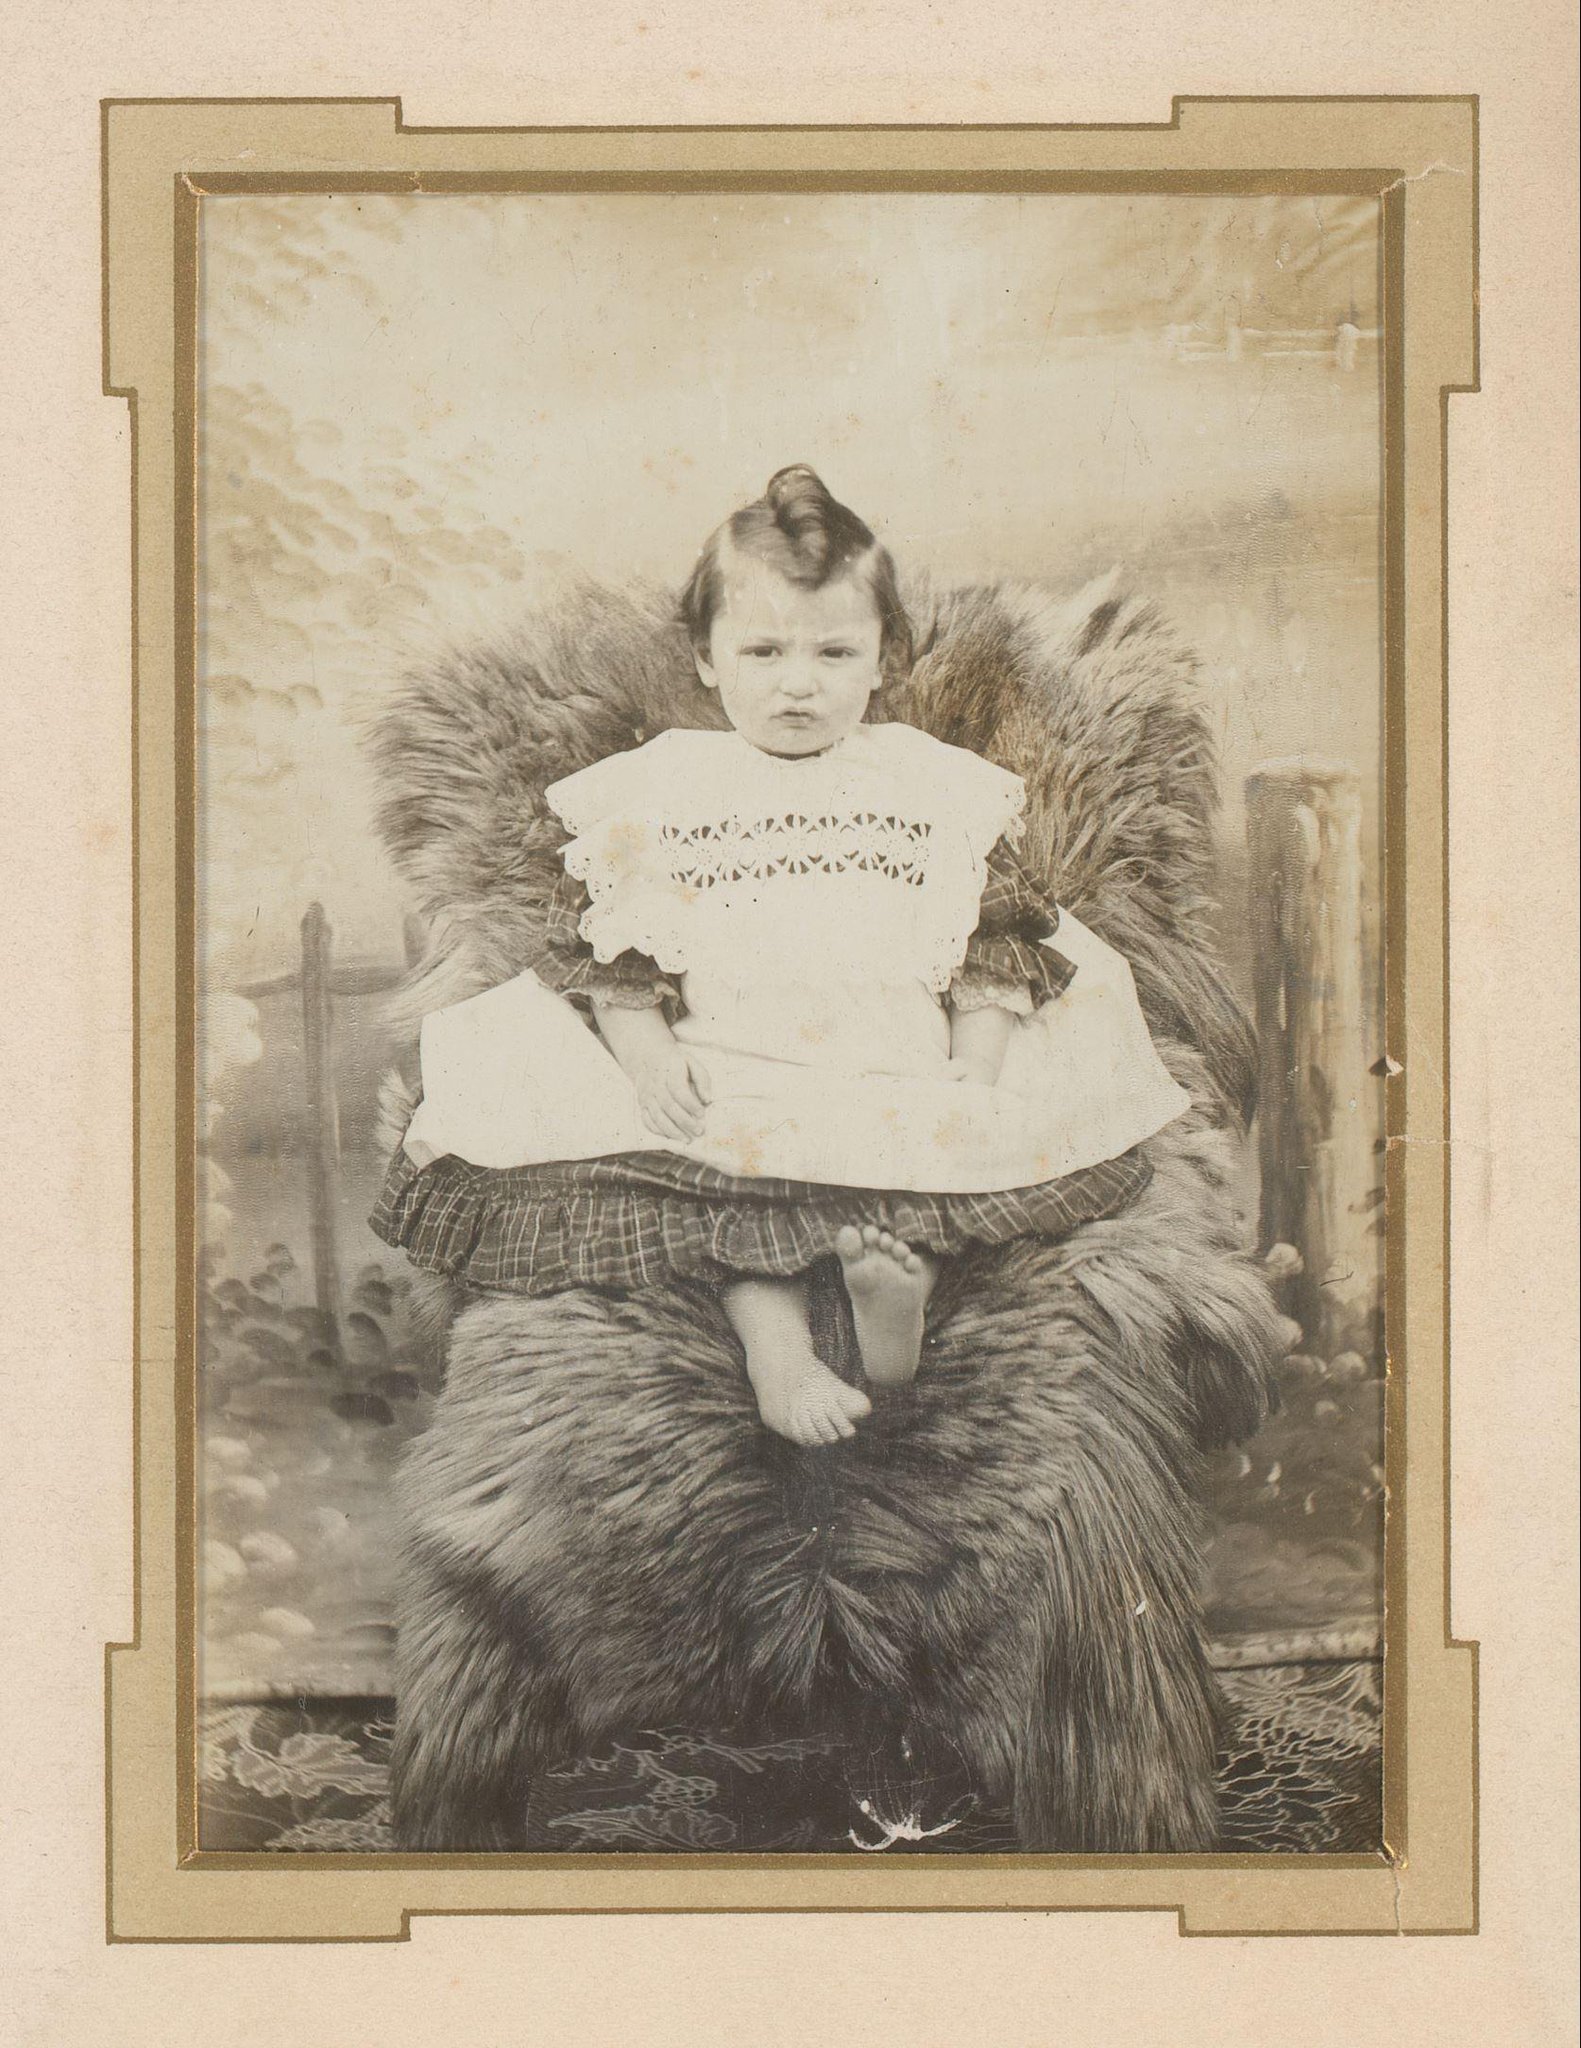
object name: photograph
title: Portret van een meisje, zittend in een stoel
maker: f. perry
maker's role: fotograaf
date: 1900-1930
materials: cardboard, photographic support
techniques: gelatin silver print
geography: sunderland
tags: historical persons - bb - woman, girl (child between toddler and youth)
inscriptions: inscription: ‘F. Berry/ 26, Nicholas St./ Hetton Downs’